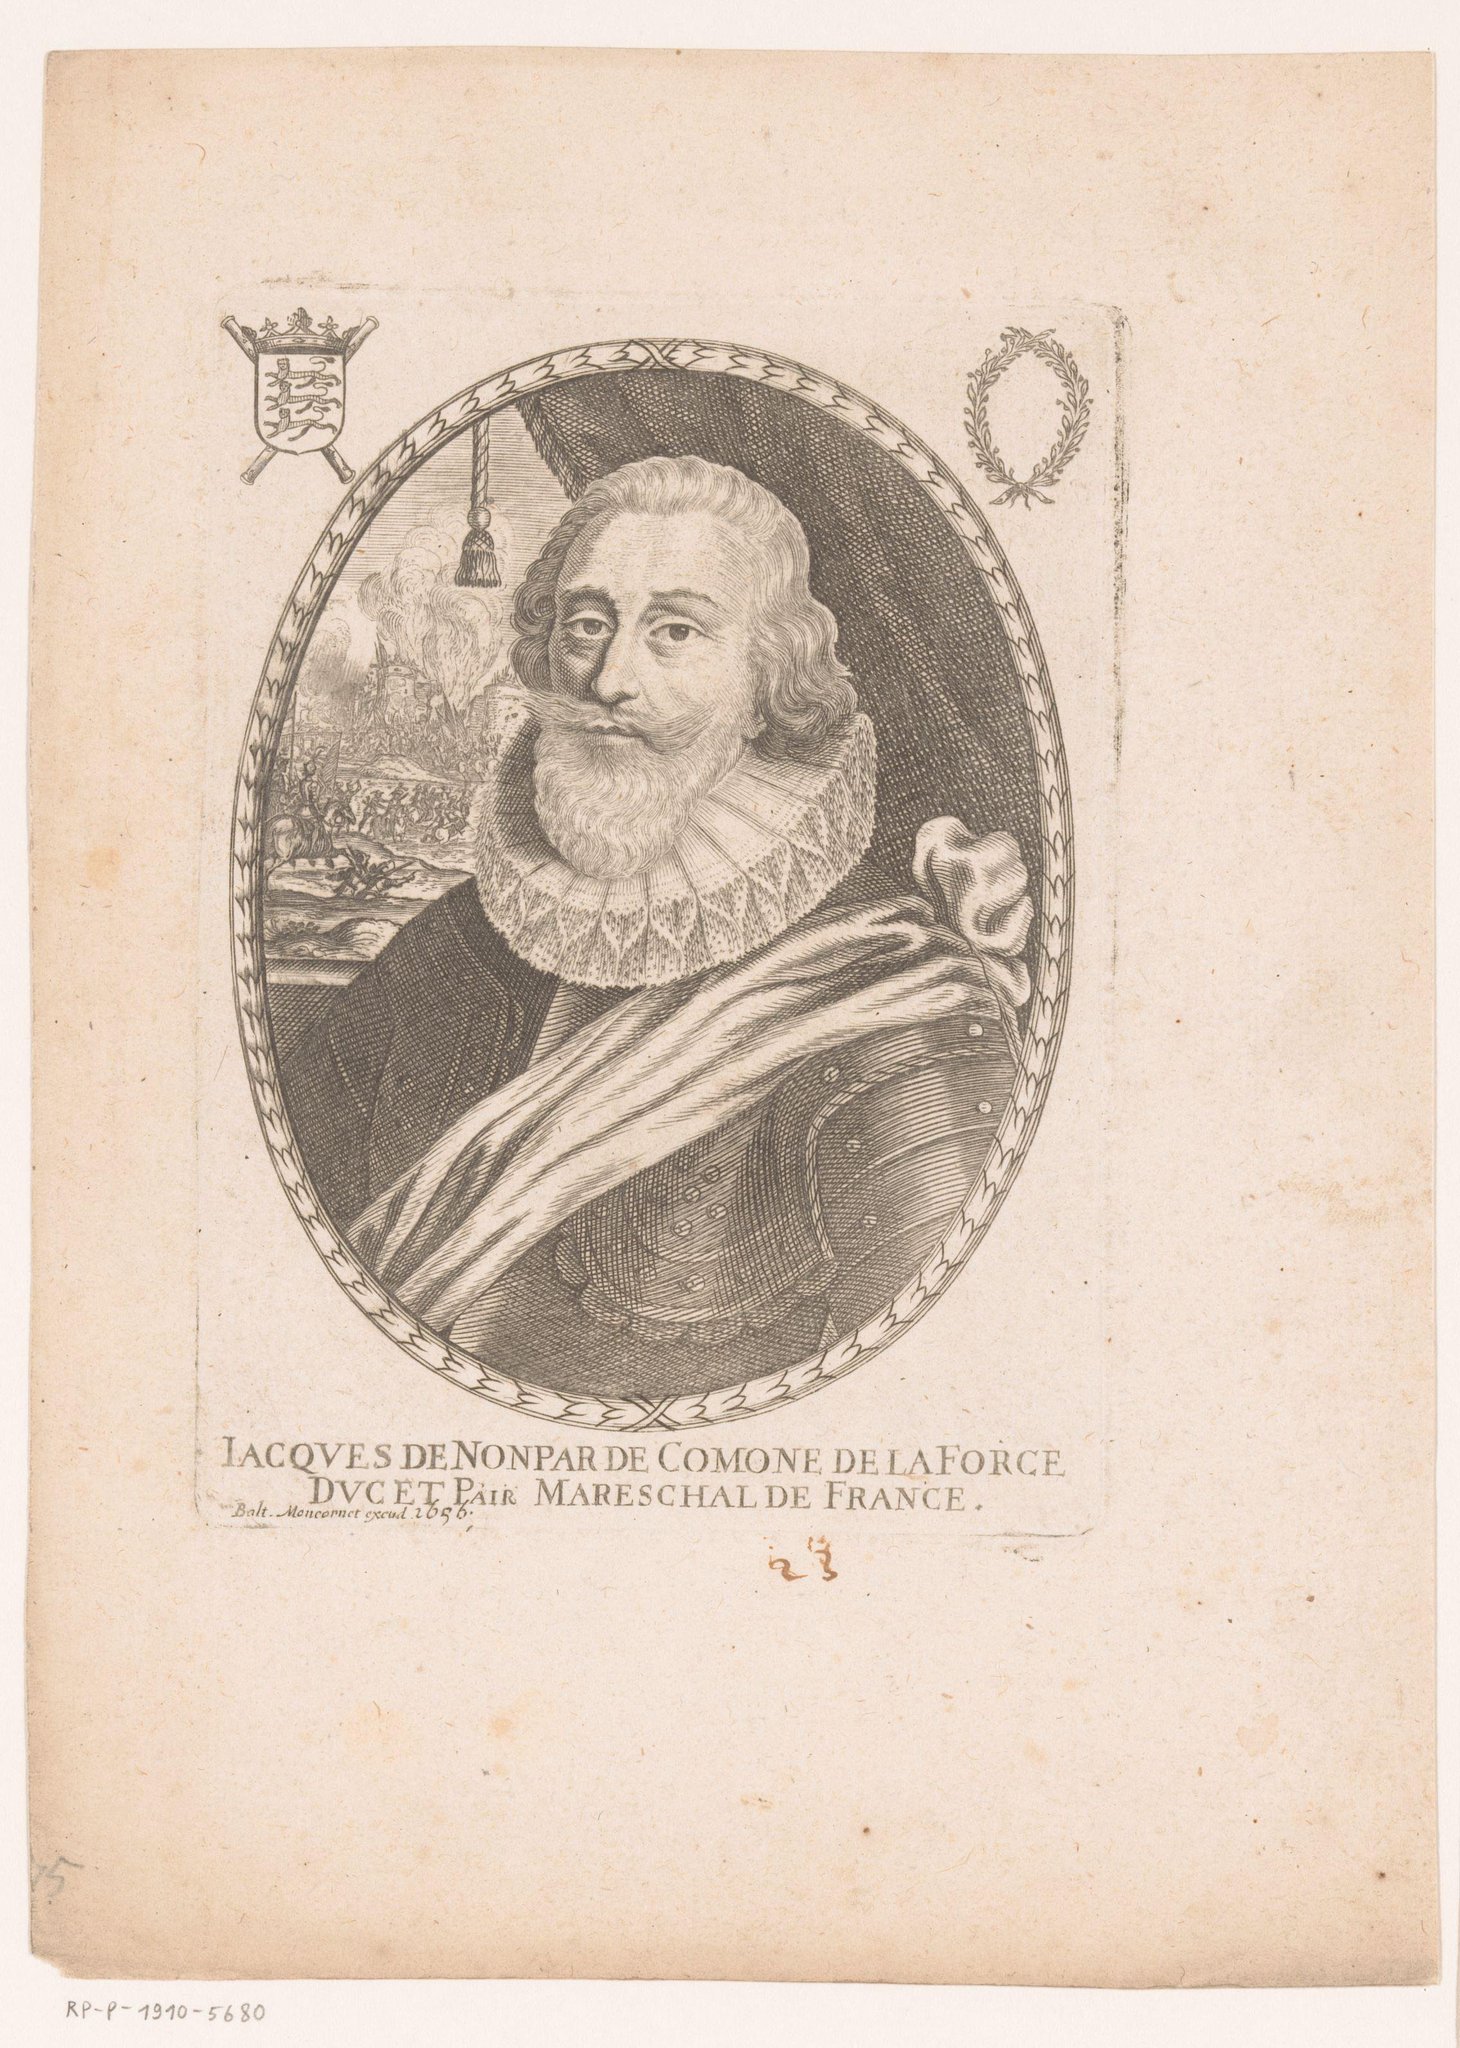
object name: print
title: Portret van Portret van Jacques-Nompar de Caumont de La Force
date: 1656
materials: paper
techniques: engraving, etching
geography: paris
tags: historical persons, armorial bearing, heraldry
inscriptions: collector's mark: Lugt 2228